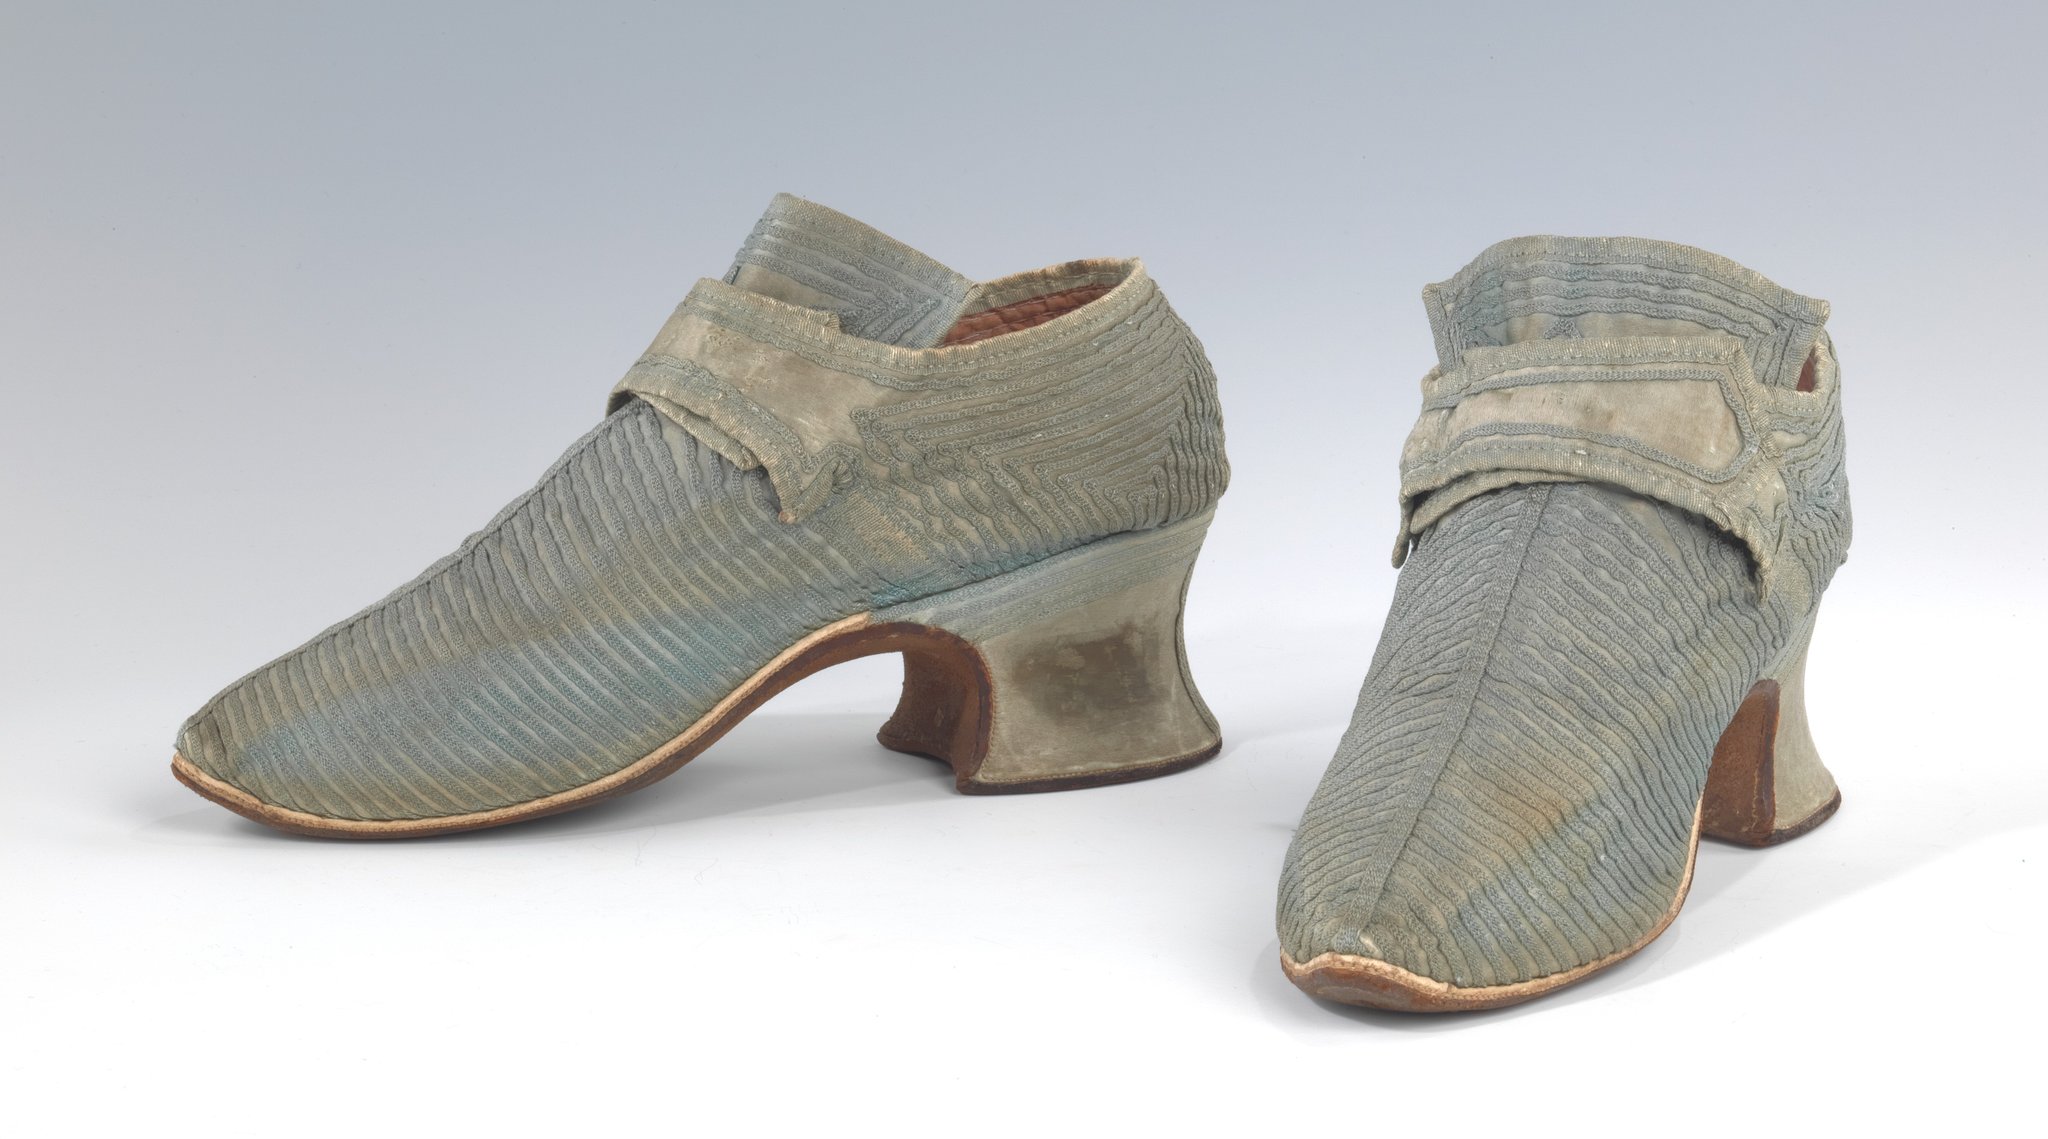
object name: shoe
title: Shoes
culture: european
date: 1730-1759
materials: silk